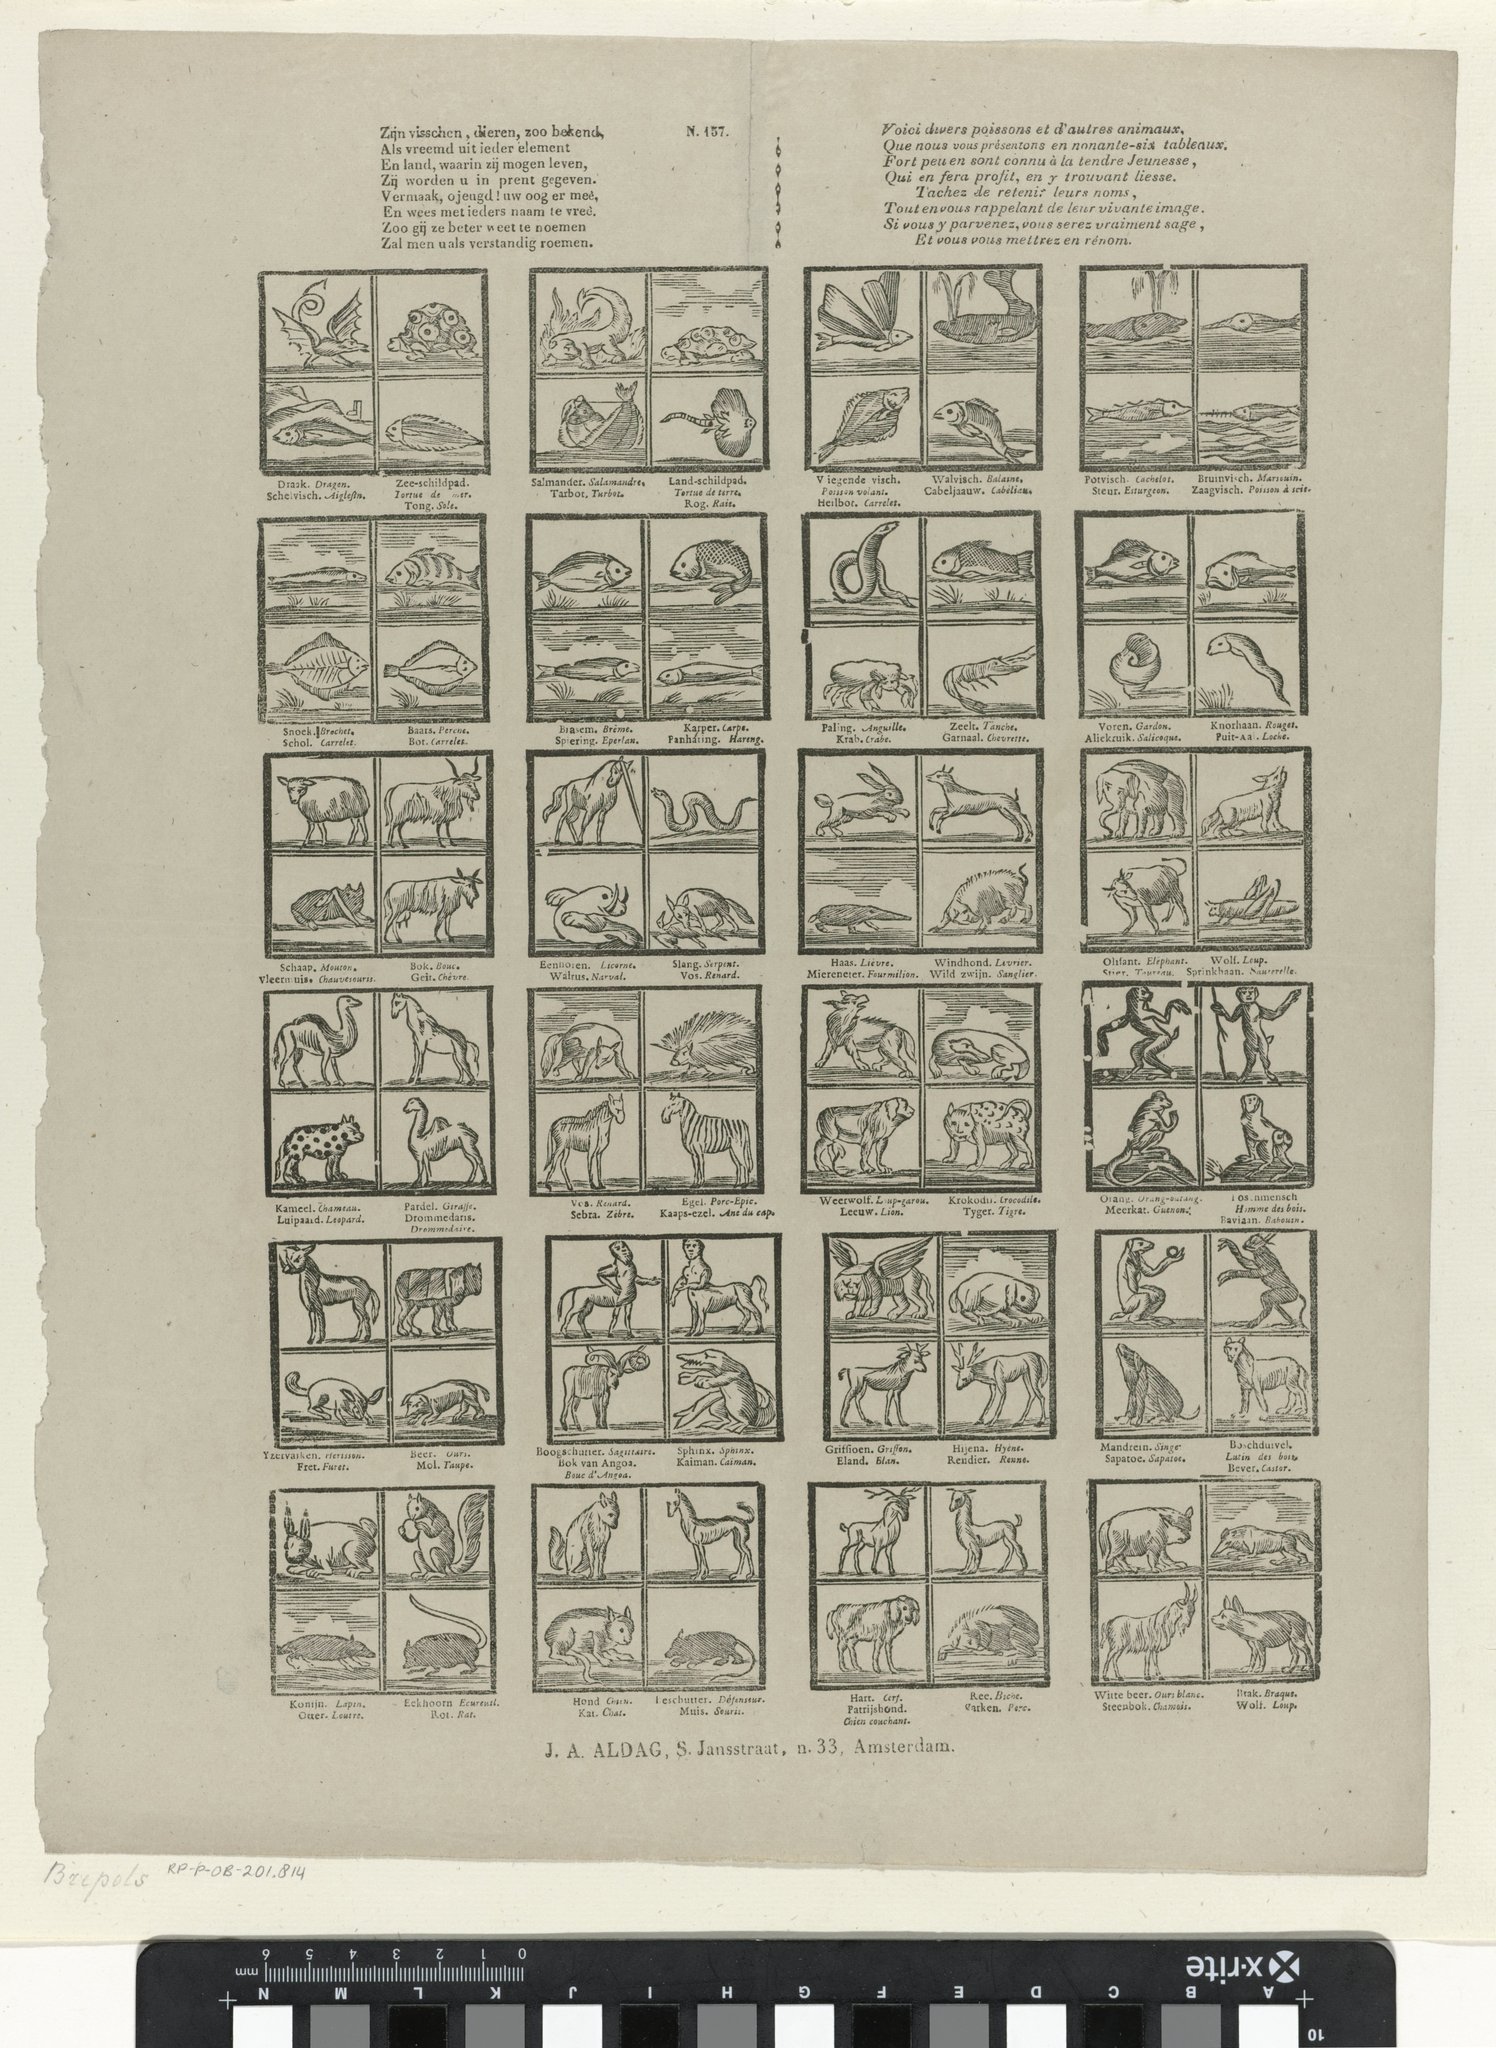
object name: popular print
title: Zijn visschen, dieren, zoo bekend, / Als vreemd uit ieder element [(...)]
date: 1851-1880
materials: paper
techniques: letterpress printing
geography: turnhout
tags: animals, cat, monkeys, apes, fishes, rodents, trunked animals: elephant, dog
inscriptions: collector's mark: Lugt 2760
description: Blad met 24 voorstellingen van in totaal 96 dieren, waaronder vissen, slangen, geiten, apen en knaagdieren. Onder elke afbeelding de namen van de dieren in het Nederlands en in het Frans. Genummerd midden boven: N. 157.